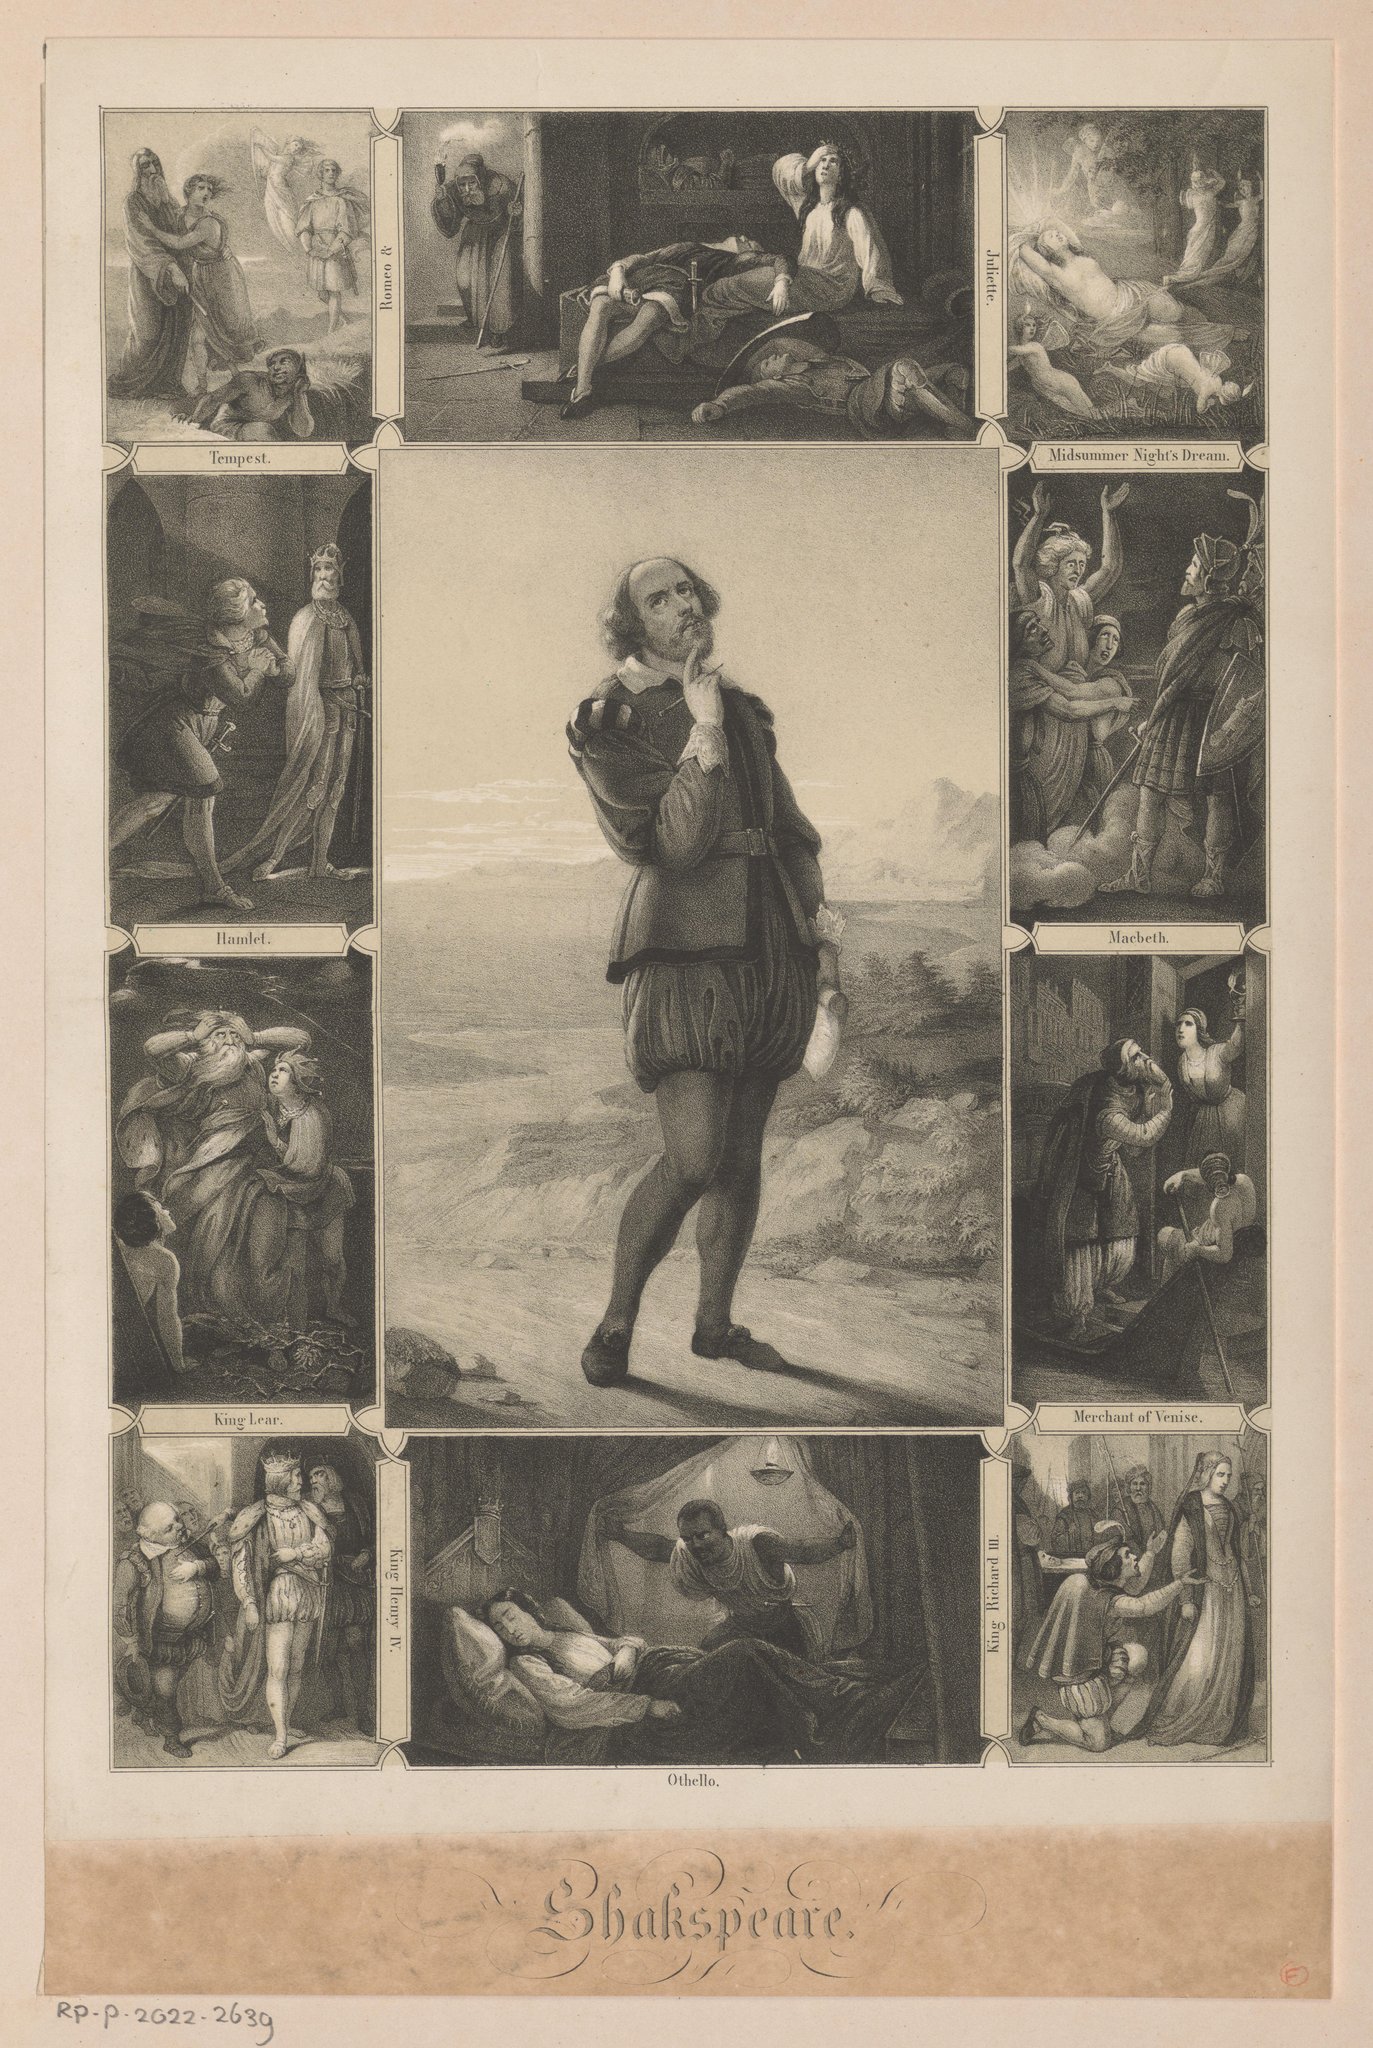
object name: print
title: Portret van William Shakespeare omringd door voorstellingen van zijn werken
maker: Anonymous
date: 1798-1899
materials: paper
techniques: tone lithography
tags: william shakespeare, historical persons, portrait of a writer